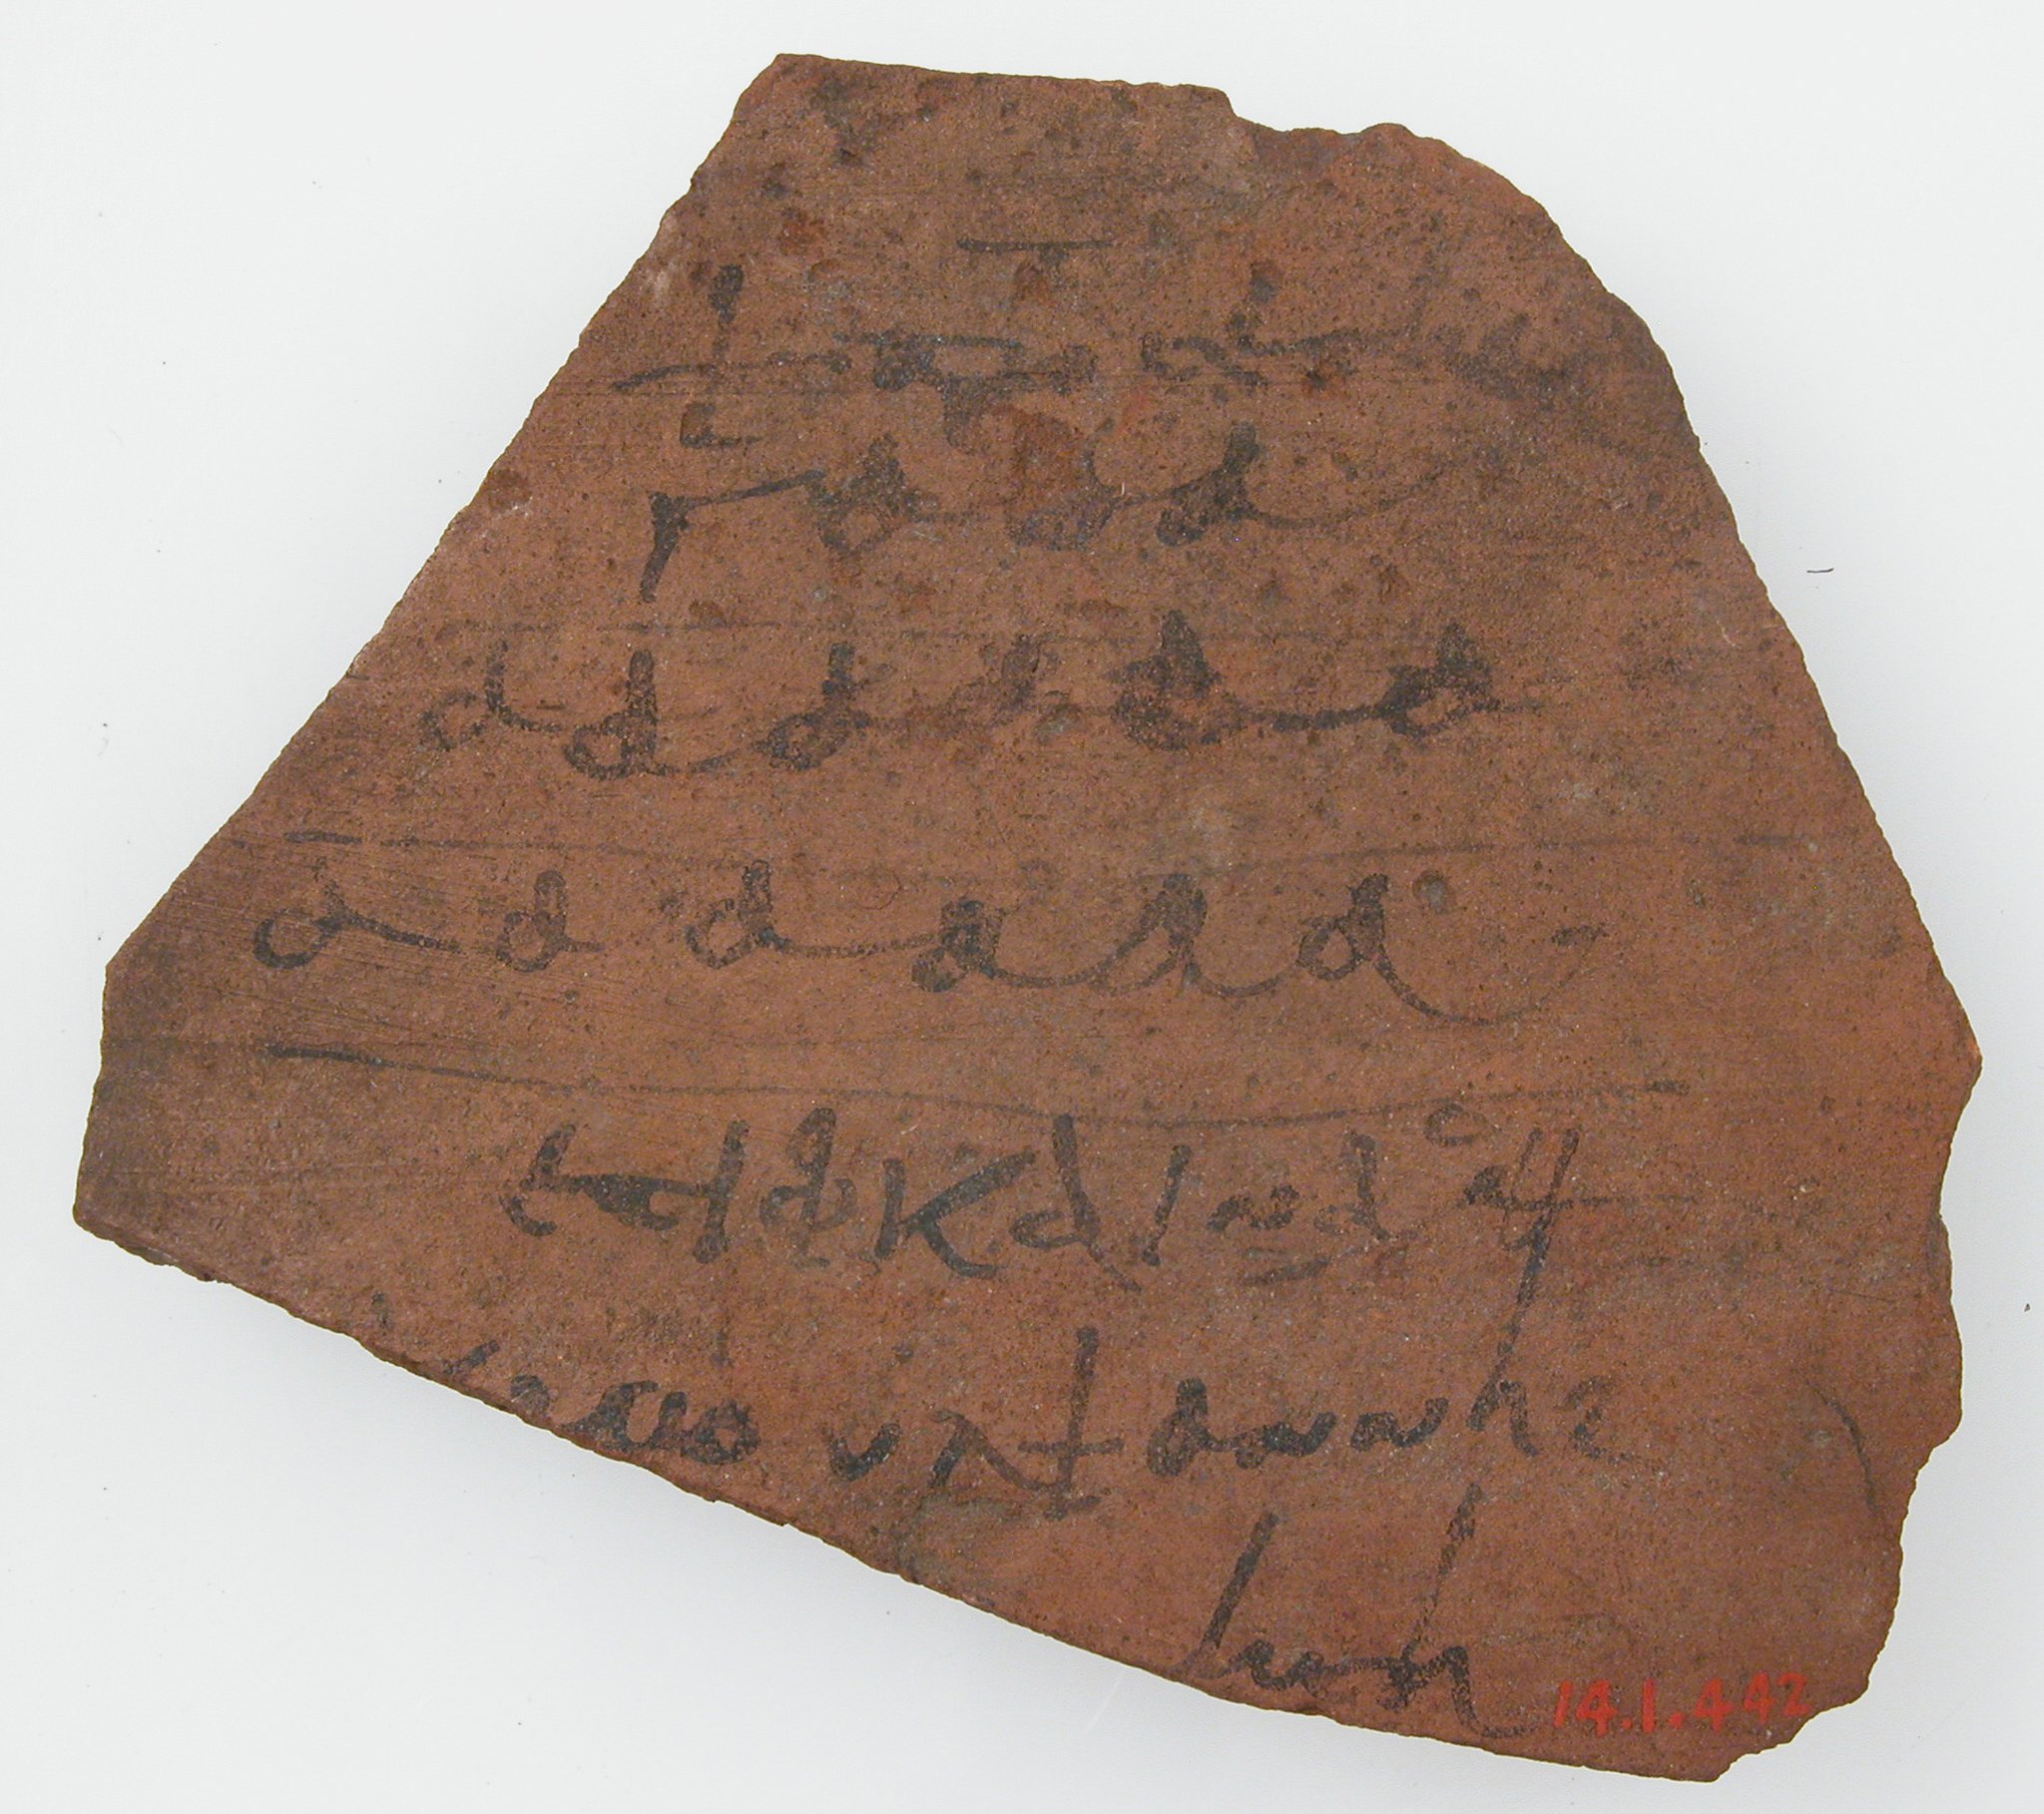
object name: ostrakon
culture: coptic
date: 580-640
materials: ink, pottery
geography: egypt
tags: coptic,documents